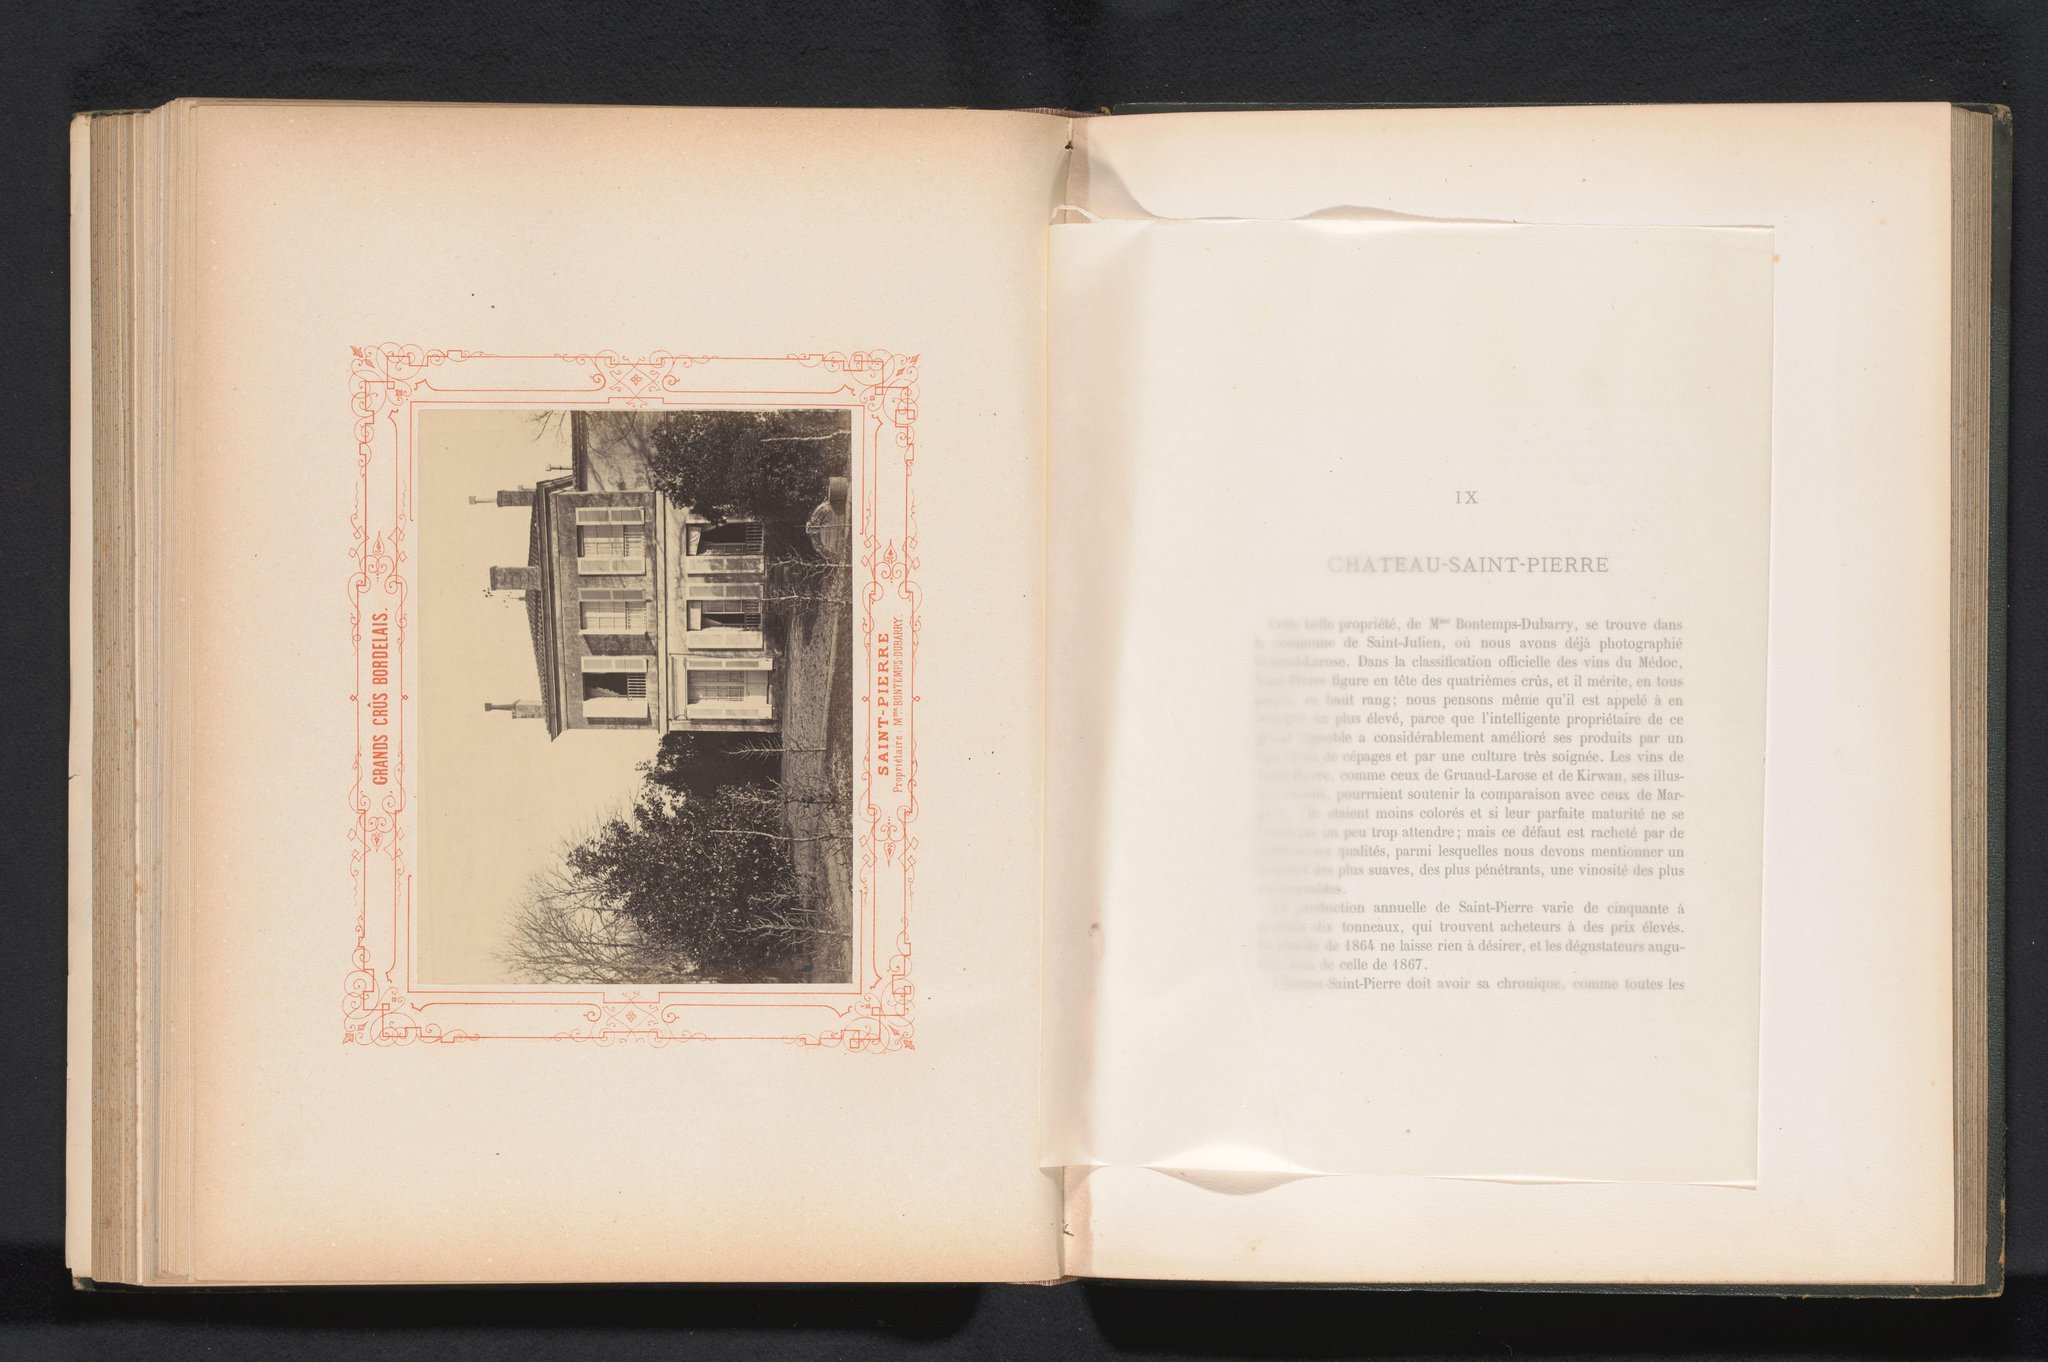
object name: page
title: Gezicht op Château Saint-Pierre in Saint-Julien-Beychevelle, Frankrijk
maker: alfred danflou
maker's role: fotograaf, schrijver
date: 1862-1867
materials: photographic support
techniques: albumen print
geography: saint-julien-beychevelle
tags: castle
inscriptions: inscription: ‘Propriétaire: Mme. BONTEMPS-DUBARRY.’